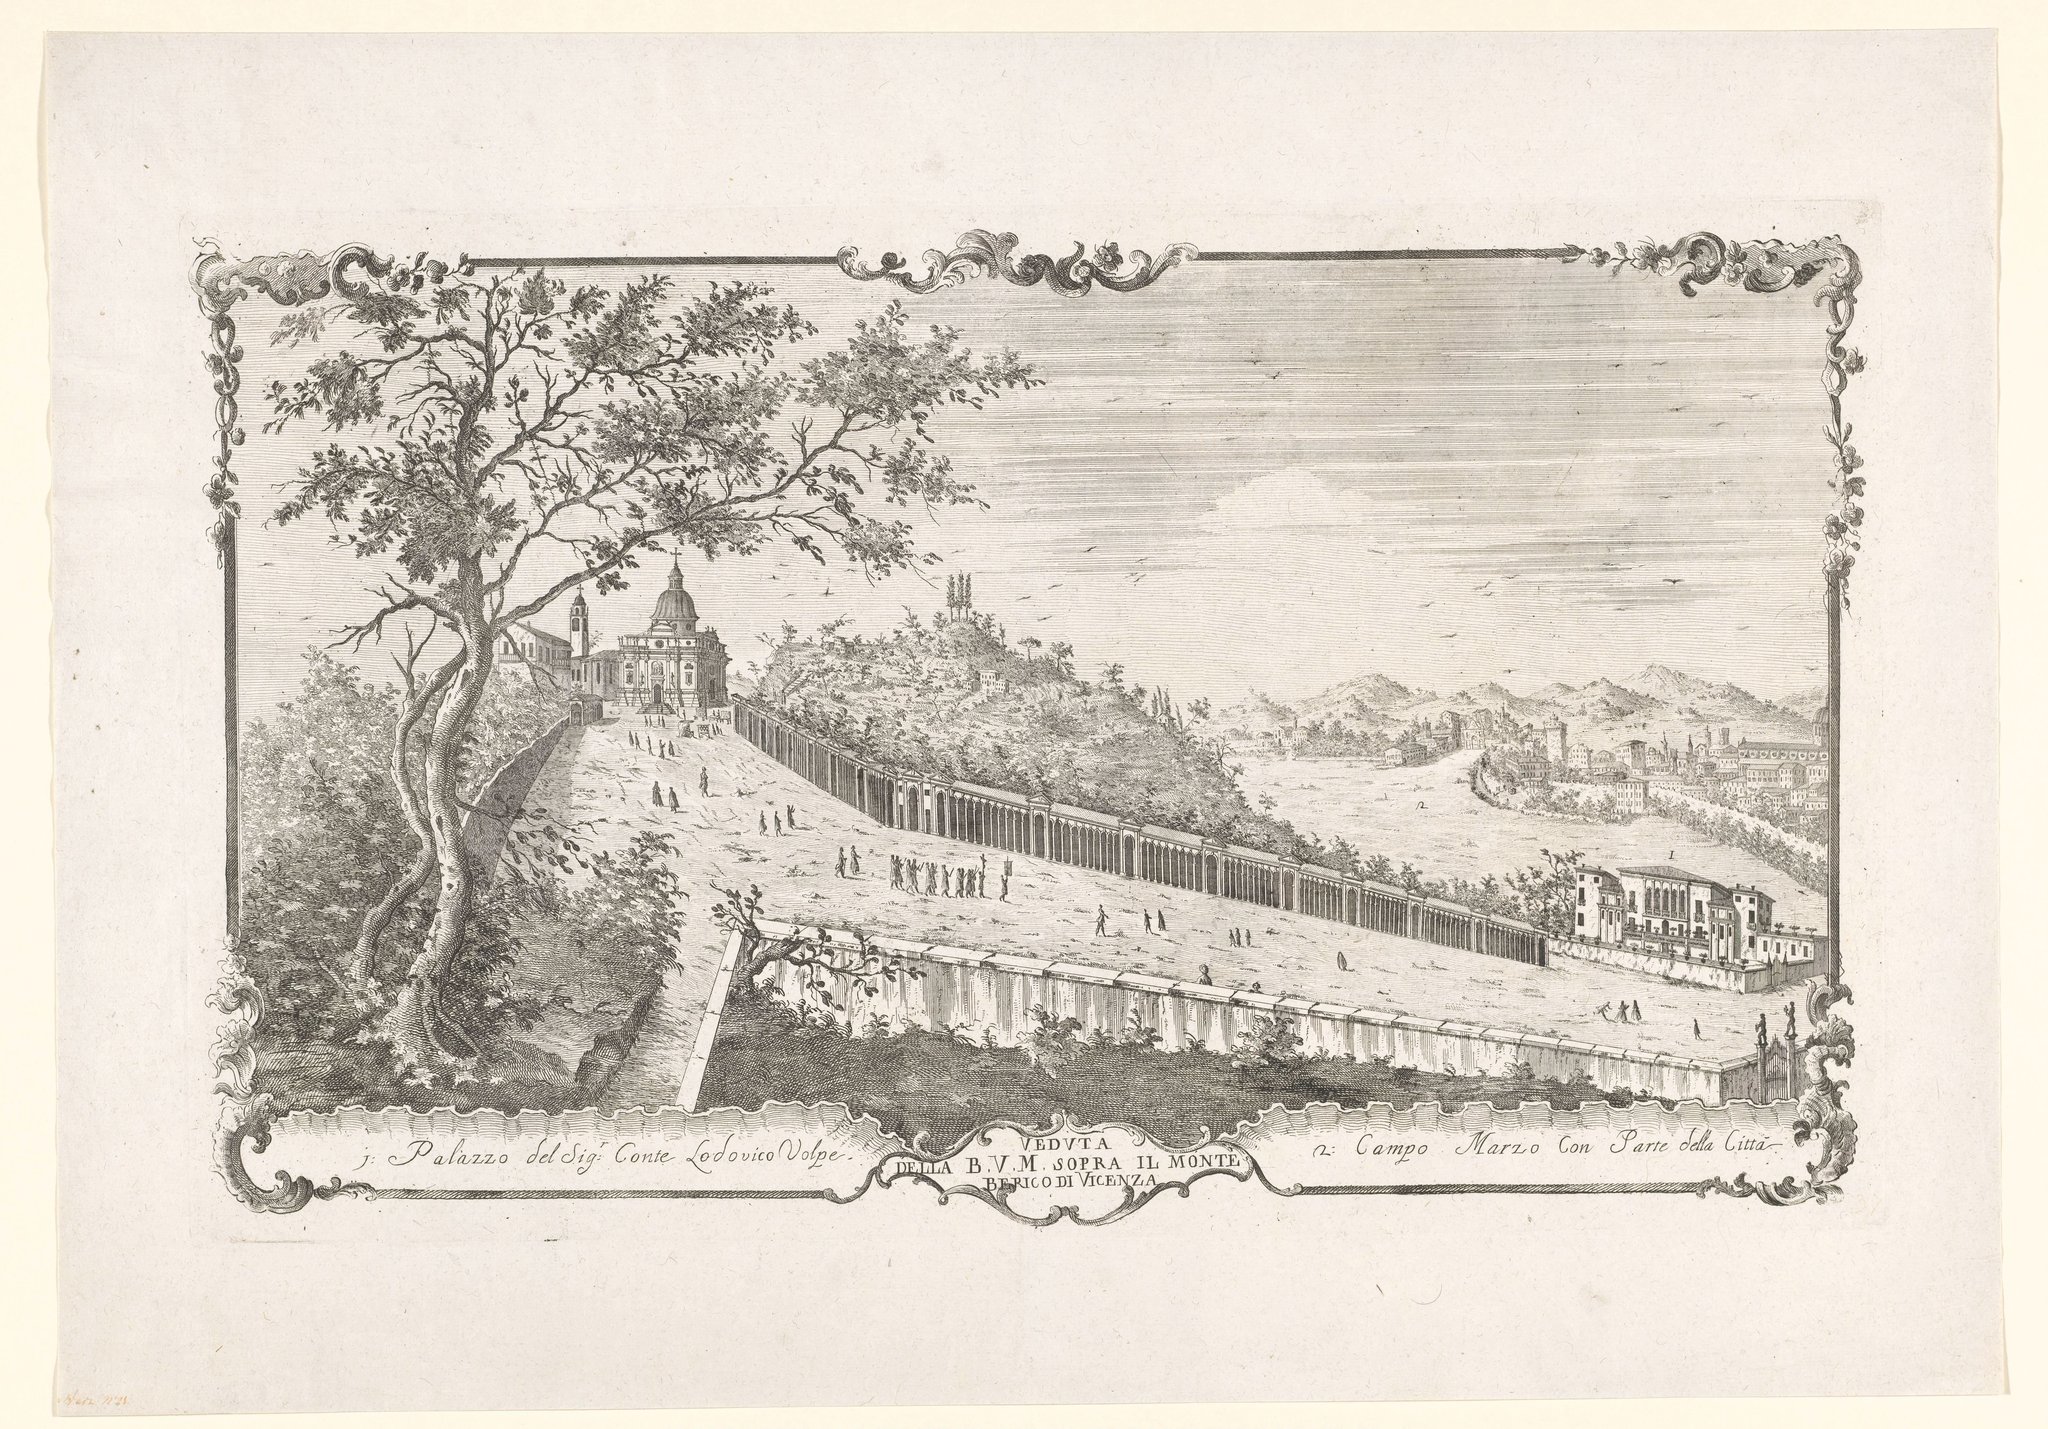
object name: print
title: De Beata Vergine Maria kerk op de Monte Berico bij Vicenza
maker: cristoforo dall acqua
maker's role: draughtsman, print maker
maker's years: 1734-1787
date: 1744-1787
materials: paper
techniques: etching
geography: italy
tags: city-view, and landscape with man-made constructions, church (exterior), hôtel, i.e. small palace in city, mountains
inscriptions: collector's mark: Lugt 2228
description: Gezicht op de Beata Vergine Maria kerk op de Monte Berico bij Vicenza. Een kleine processie loopt de berg af achter een vaandeldrager en een man met een kruisbeeld. Onder aan de berg het Palazzo van Ludovico Volpe. Verklarende lijst met nummers en titel in cartouche in ondermarge.